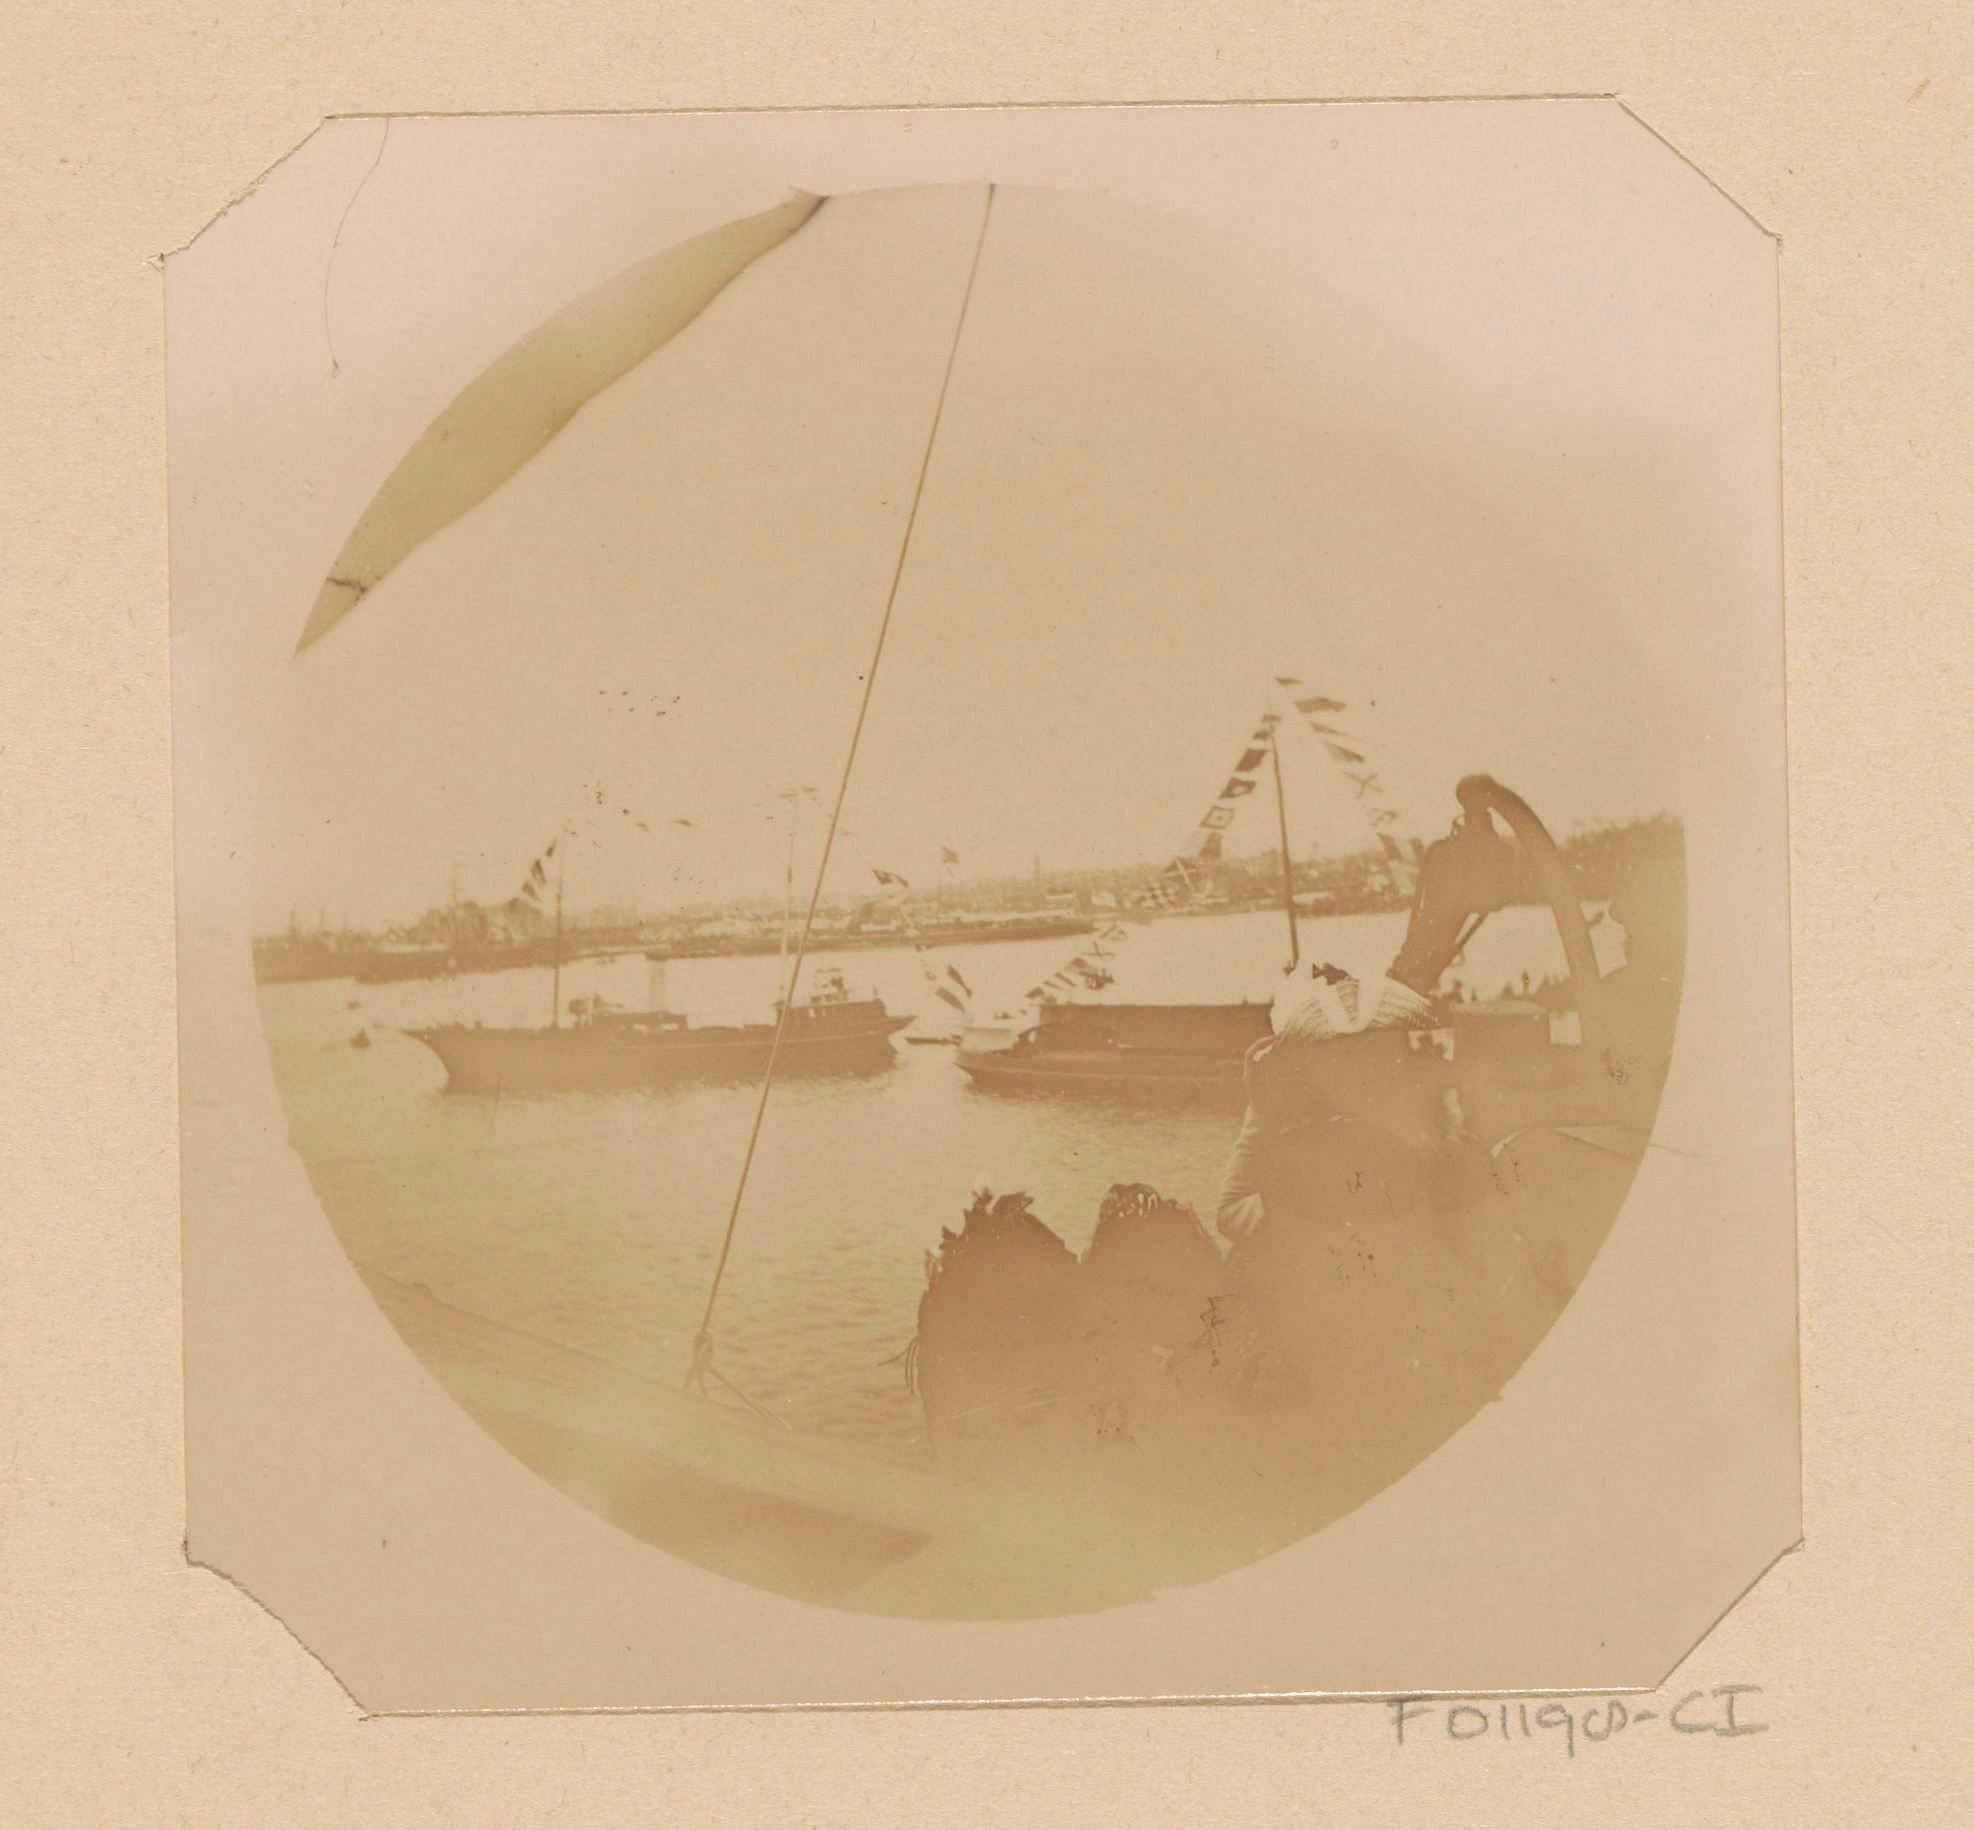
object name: album leaf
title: Keizersfeesten 1891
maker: johanna margaretha piek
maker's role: fotograaf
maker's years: 1870-1947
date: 1891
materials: paper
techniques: gelatin silver print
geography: amsterdam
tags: harbour, imperial celebrations 1891